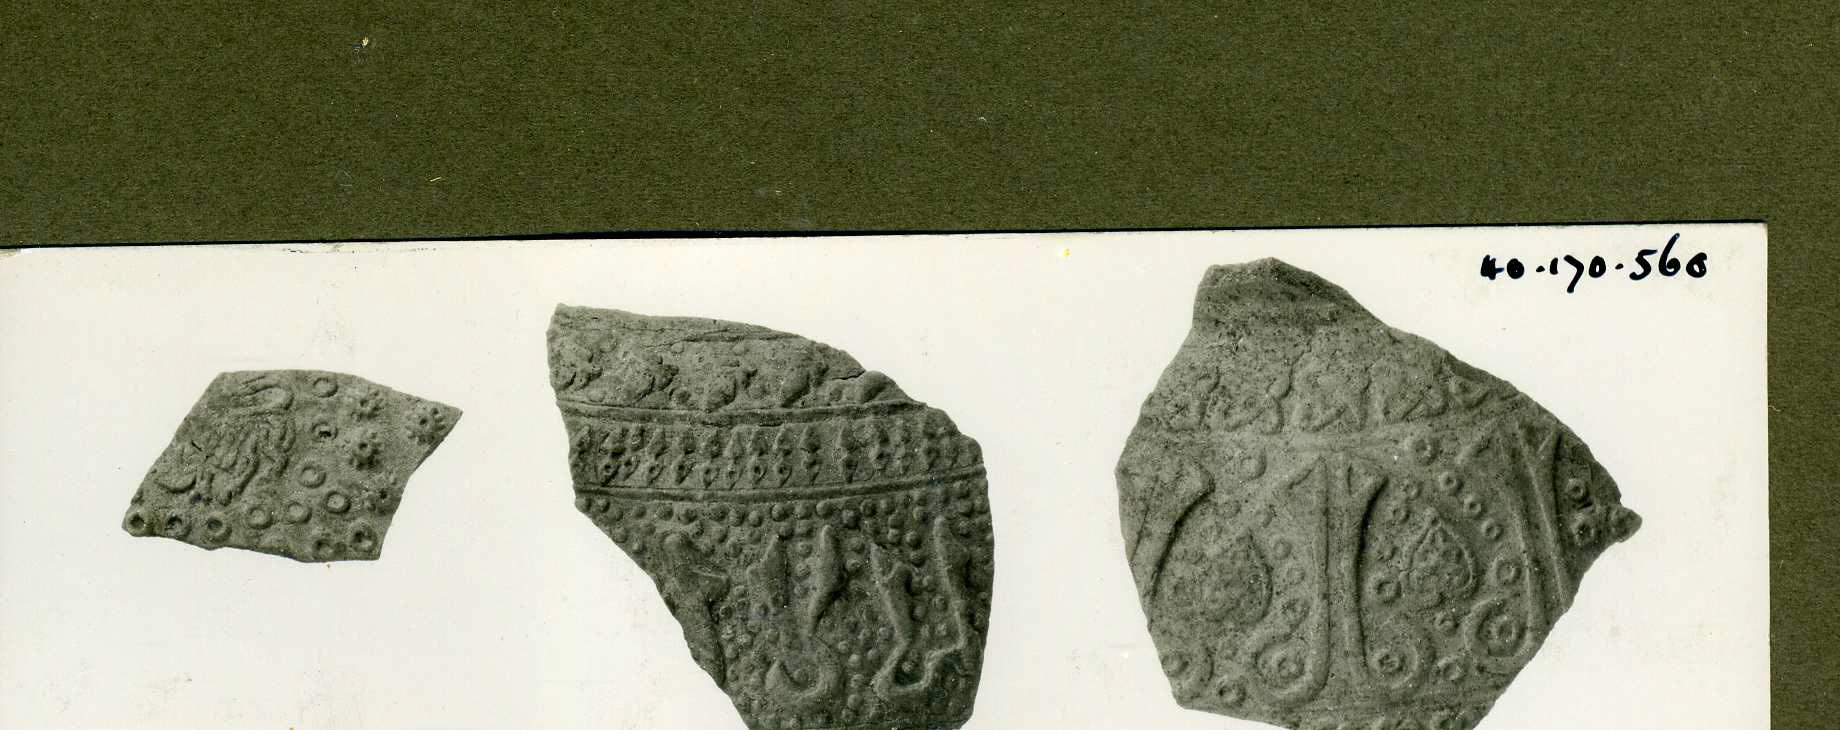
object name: fragment of a bowl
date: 801-1000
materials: earthenware, glaze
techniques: polychrome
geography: iran